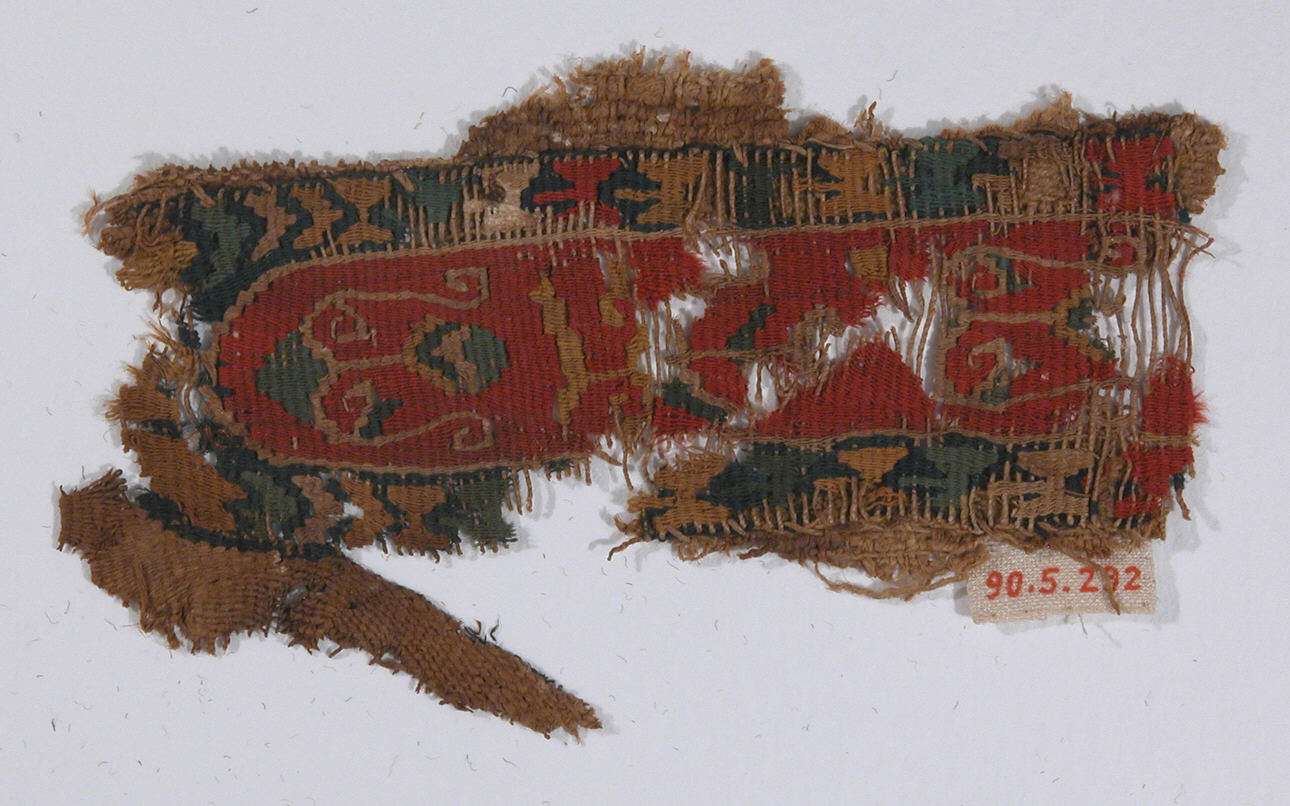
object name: textile fragment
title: Fragment of a Shoulder Band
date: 501-600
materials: linen, wool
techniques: weave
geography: egypt